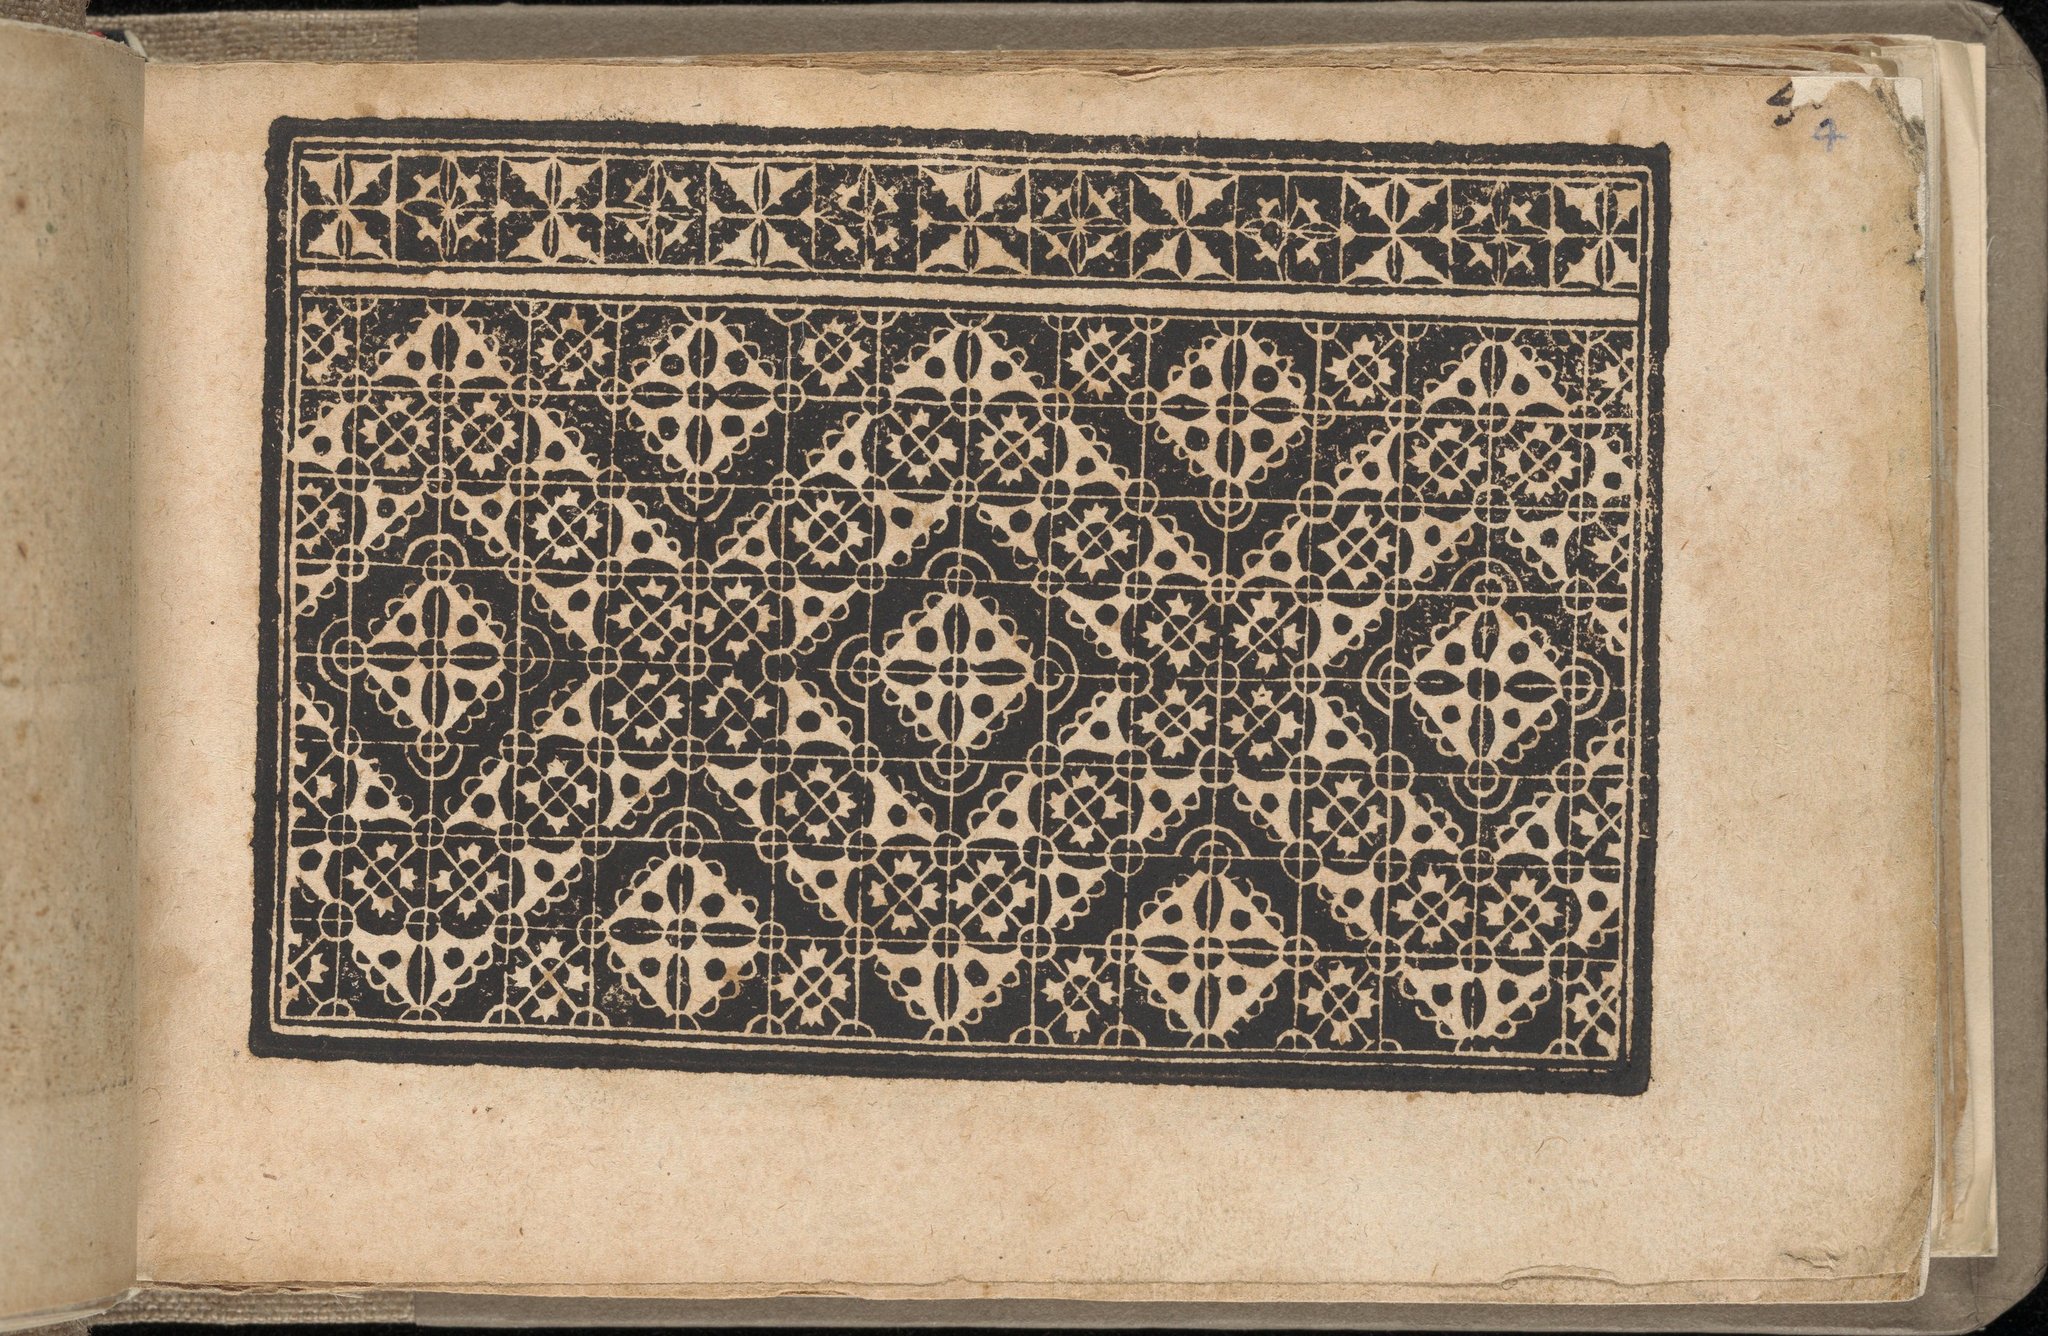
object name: book print ornament architecture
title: Schön newes Modelbuch (Page 4r)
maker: sigismundus latomus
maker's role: publisher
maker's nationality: german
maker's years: 1599-1632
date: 1608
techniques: woodcut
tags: ornament